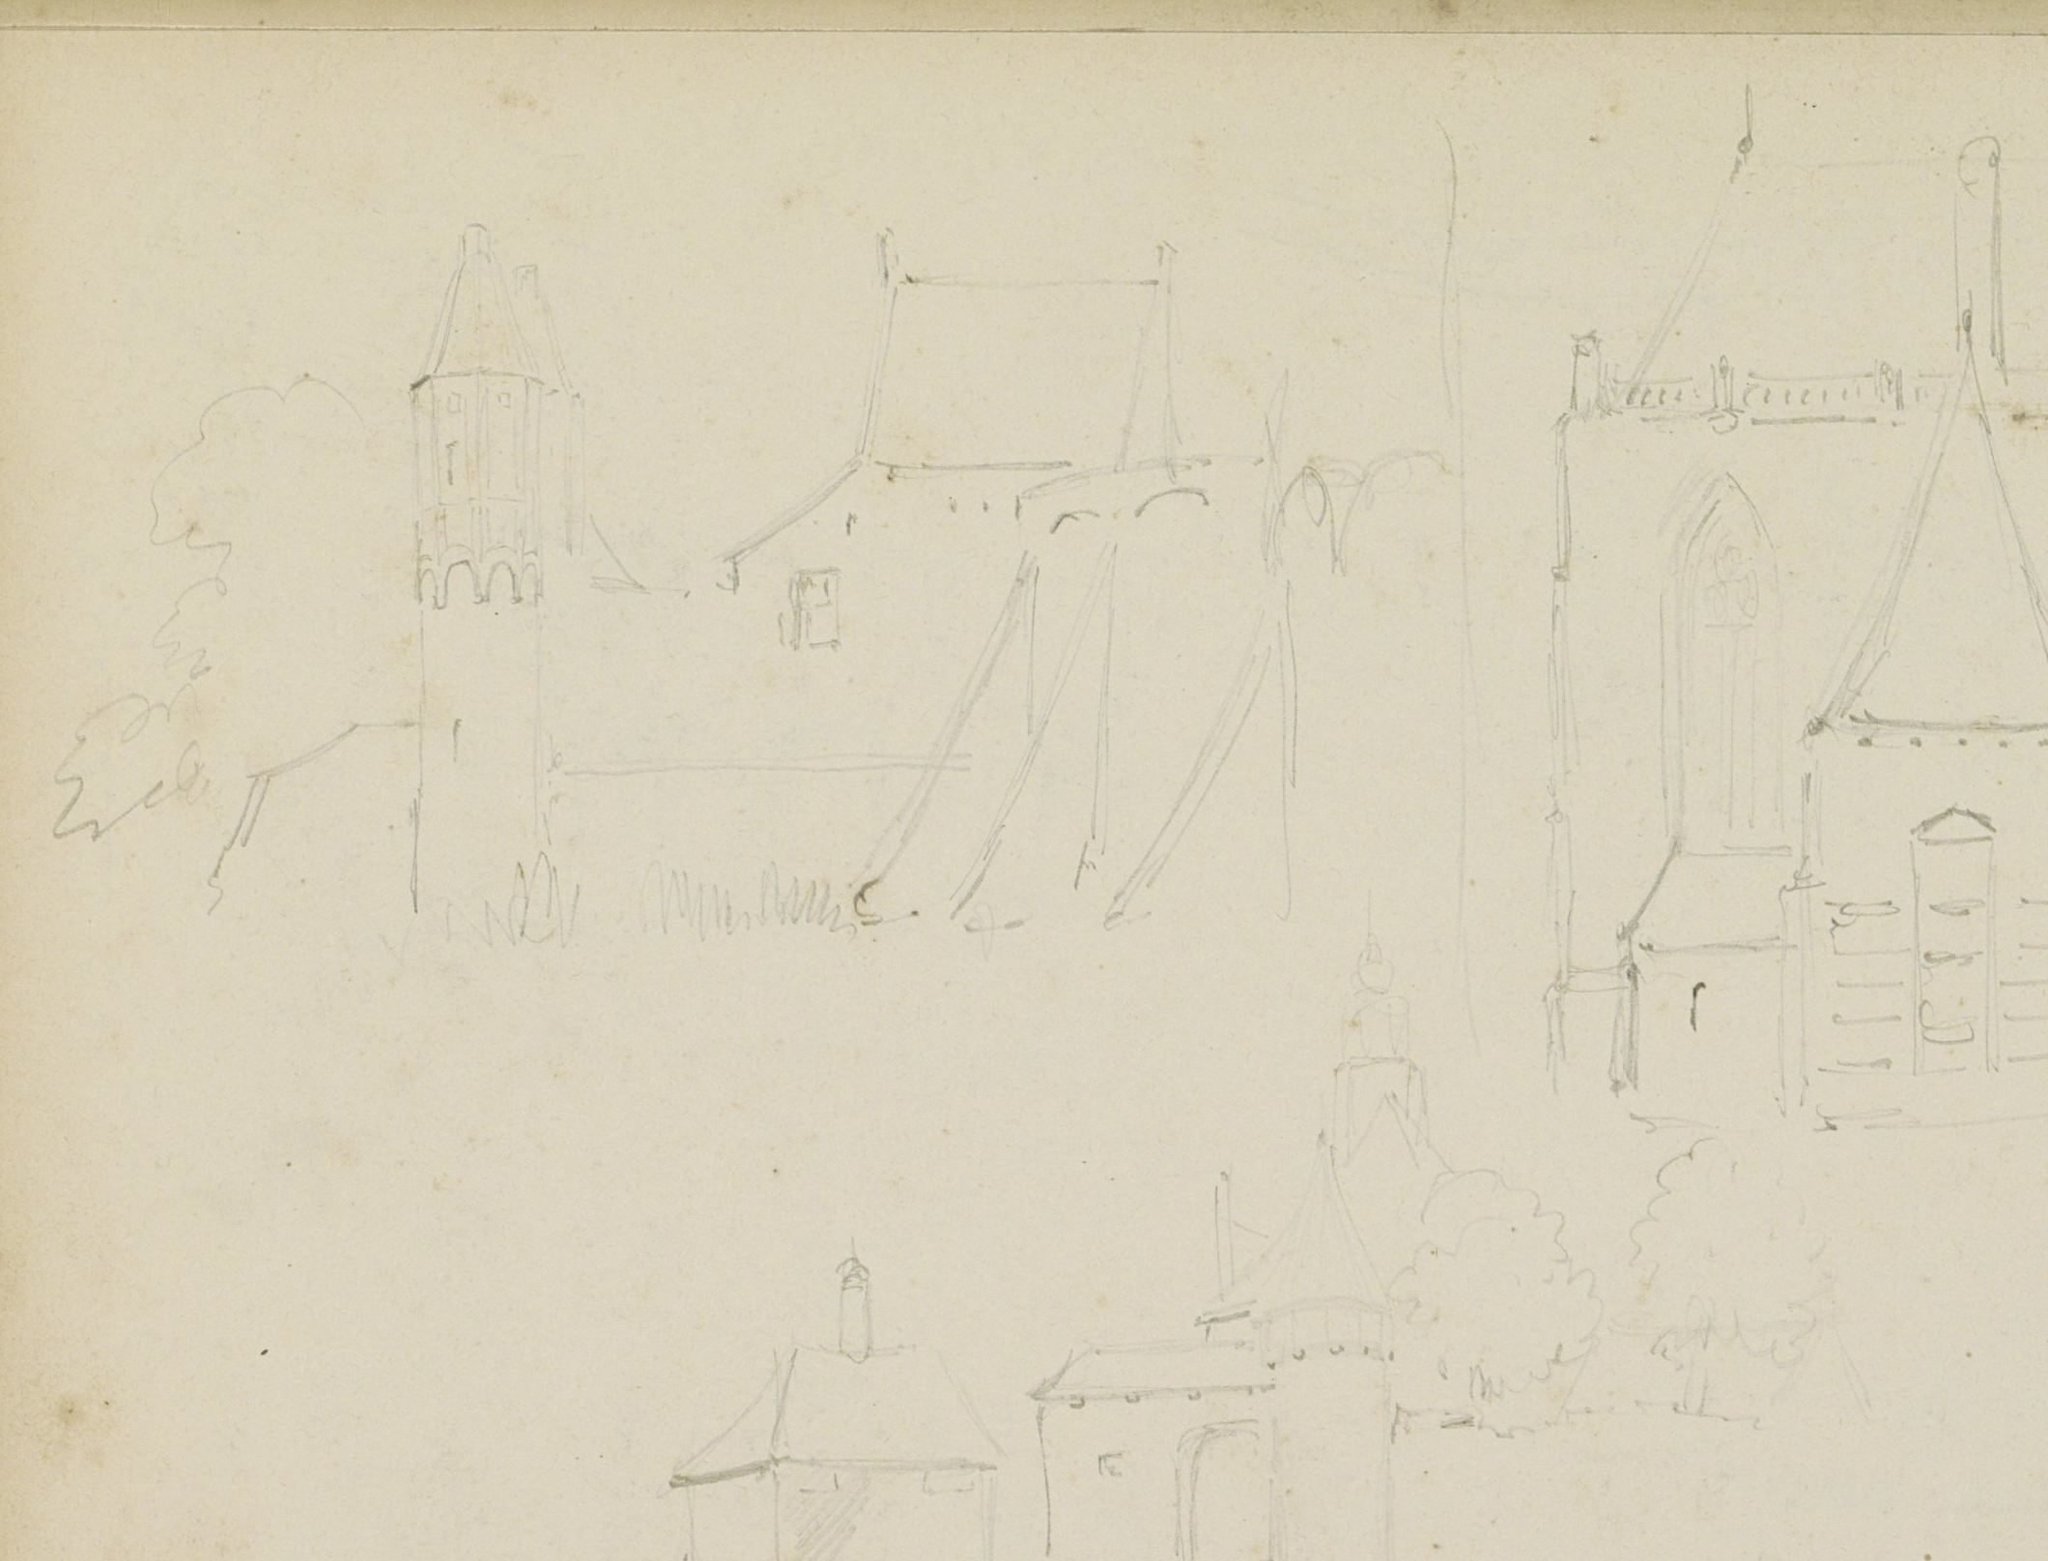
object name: sketchbook leaf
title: Studieblad met gebouwen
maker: adrianus eversen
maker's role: draughtsman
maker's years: 1818-1897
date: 1828-1897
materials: paper, pencil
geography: netherlands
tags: city-view, and landscape with man-made constructions, castle, church (exterior), bridge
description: Studieblad met gebouwen. Linksboven een gezicht op een gebouw met twee torens. Rechtsboven een gezicht op een deel van een kerk met een klein gebouw ervoor. Onder een brug over water met rechts een versterkt gebouw of kerk. Blad 12 verso uit een schetsboek met 41 bladen.